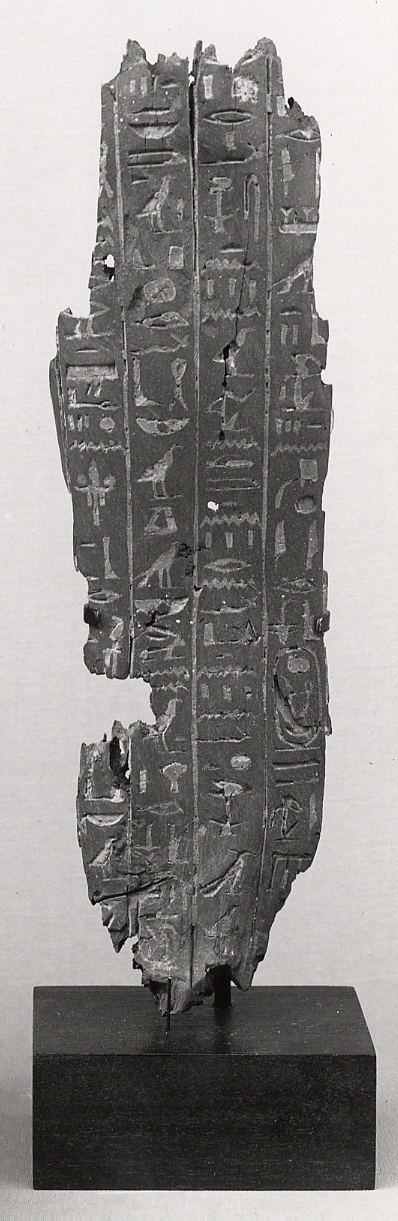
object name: shabti, amenhotep iii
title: Shabti of Amenhotep III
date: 1390-1352 BCE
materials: wood, paste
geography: egypt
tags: hieroglyphs